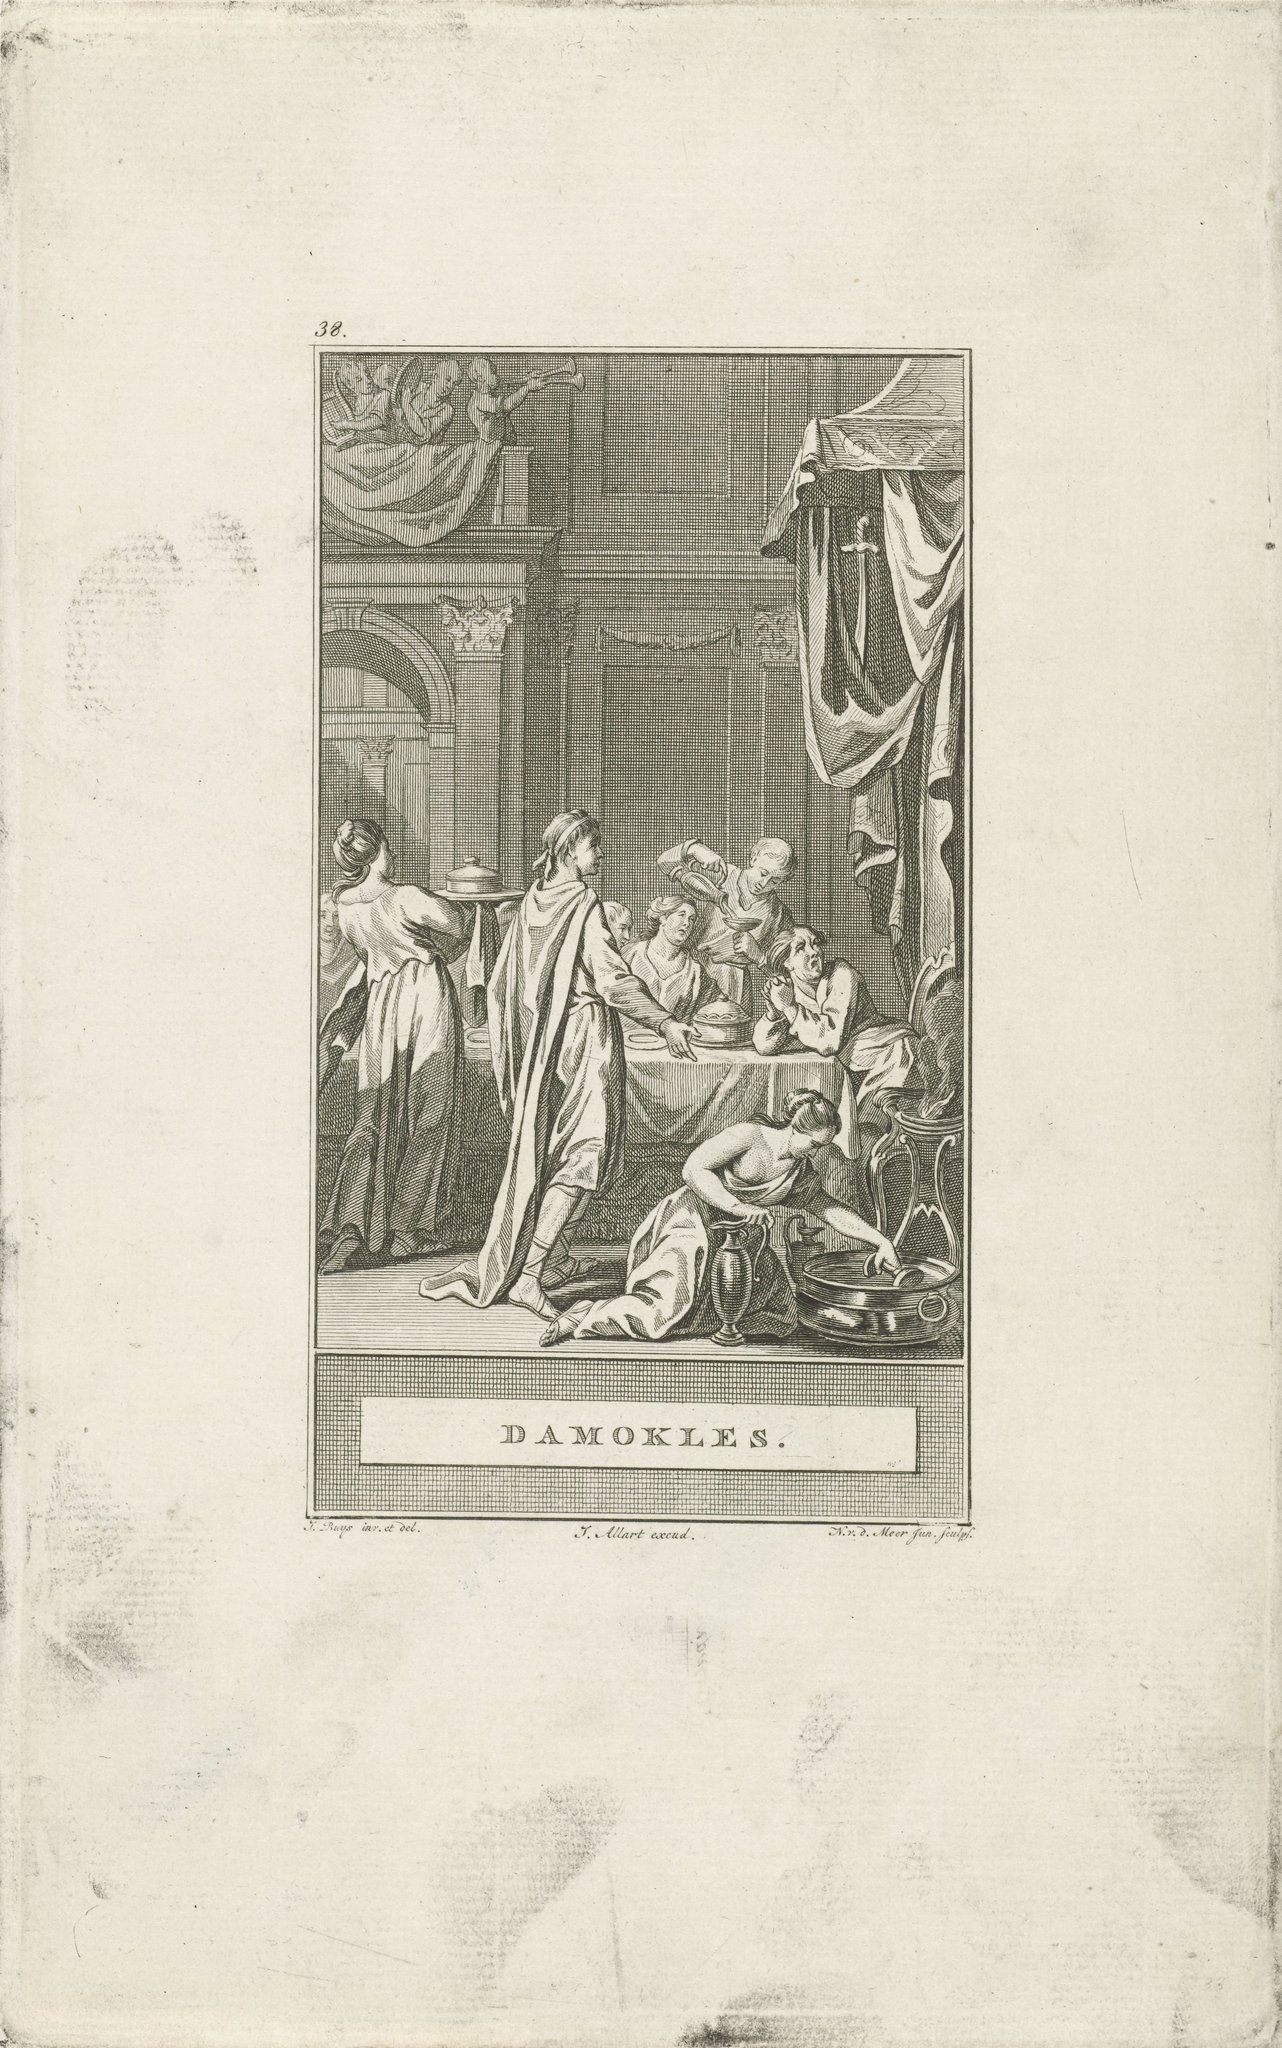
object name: print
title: Zwaard van Damocles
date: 1778-1785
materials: paper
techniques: etching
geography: amsterdam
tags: sword of damocles, damocles, courtier of dionysius i the elder, tyrant of syracuse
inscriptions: collector's mark: Lugt 2228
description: Prent bij: Gellert, Christian Fürchtegott. Fabelen en vertelsels. 3 dln. Amsterdam: Pieter Meyer, 1772-1774. De prenten bij deze publicatie werden later uitgegeven. De exemplaren uitgegeven door de weduwe Jacobus Loveringh & Johannes Allart tussen 1777 en 1778, de exemplaren uitgegeven door alleen Johannes Allart tussen 1778 en 1785.